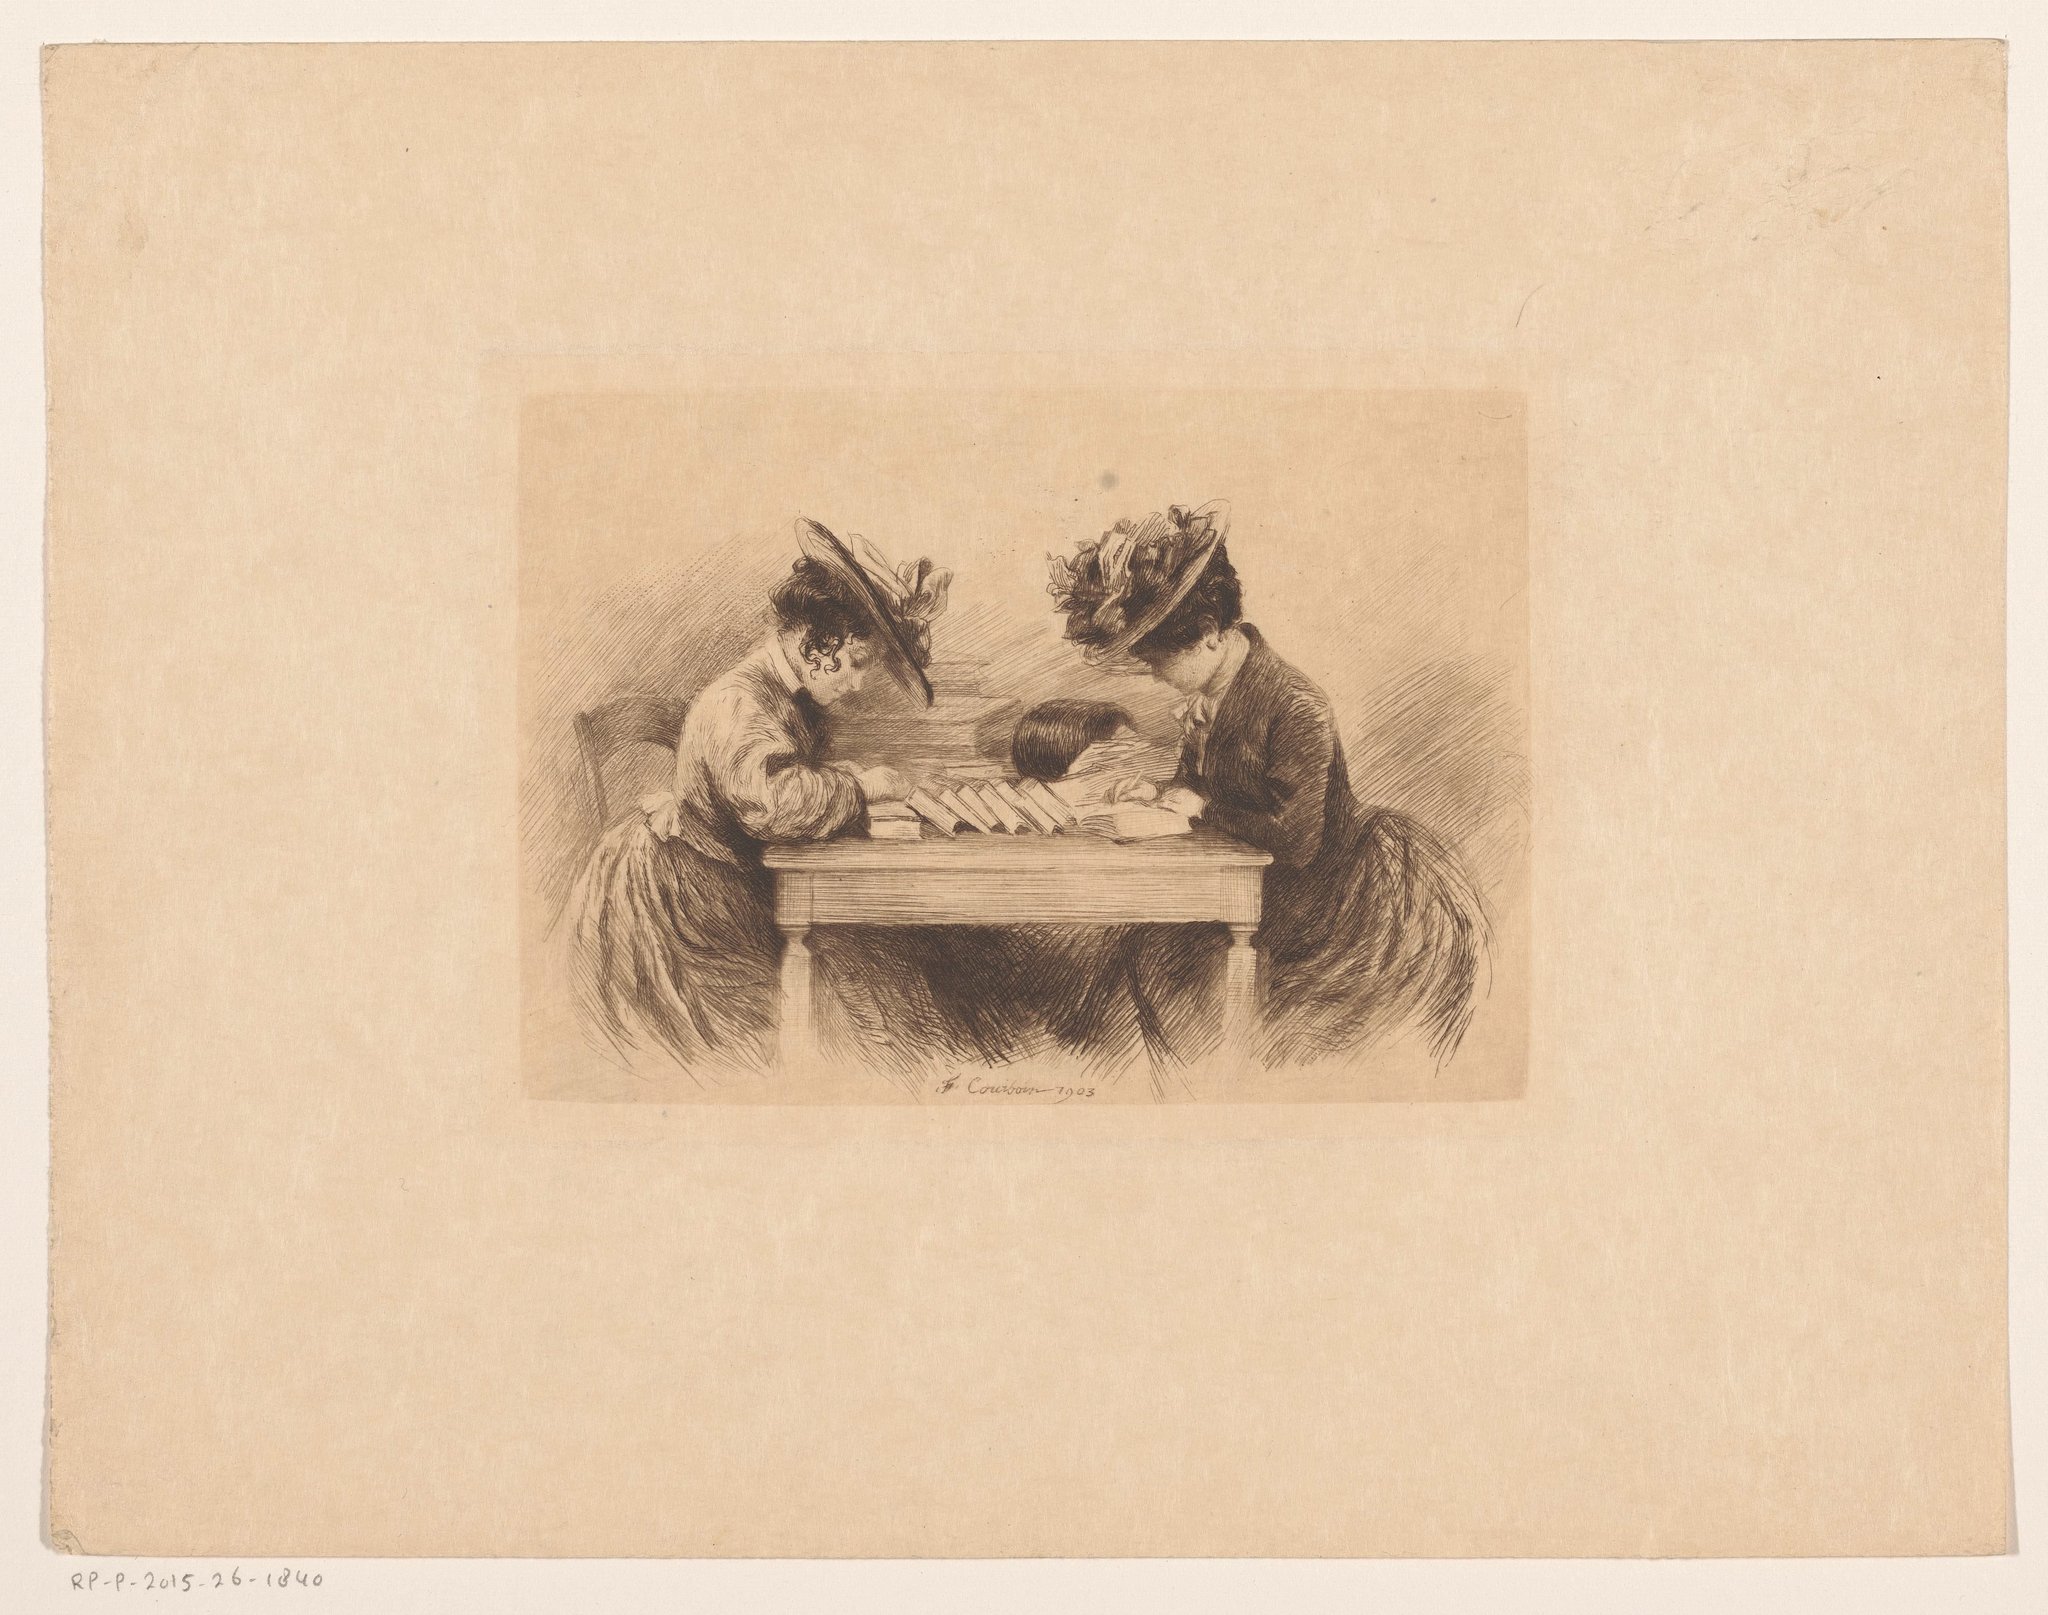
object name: print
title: Twee vrouwen met hoeden aan een schrijftafel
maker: françois courboin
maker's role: print maker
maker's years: 1865-1926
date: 1903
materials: paper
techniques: drypoint, etching, intaglio, roulette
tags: writing-table, writing-desk, handwriting, writing as activity, reading, book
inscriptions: collector's mark: Lugt 4779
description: Op tafel liggen verschillende boeken. De vrouw rechts schrijft in een opengeslagen boek.